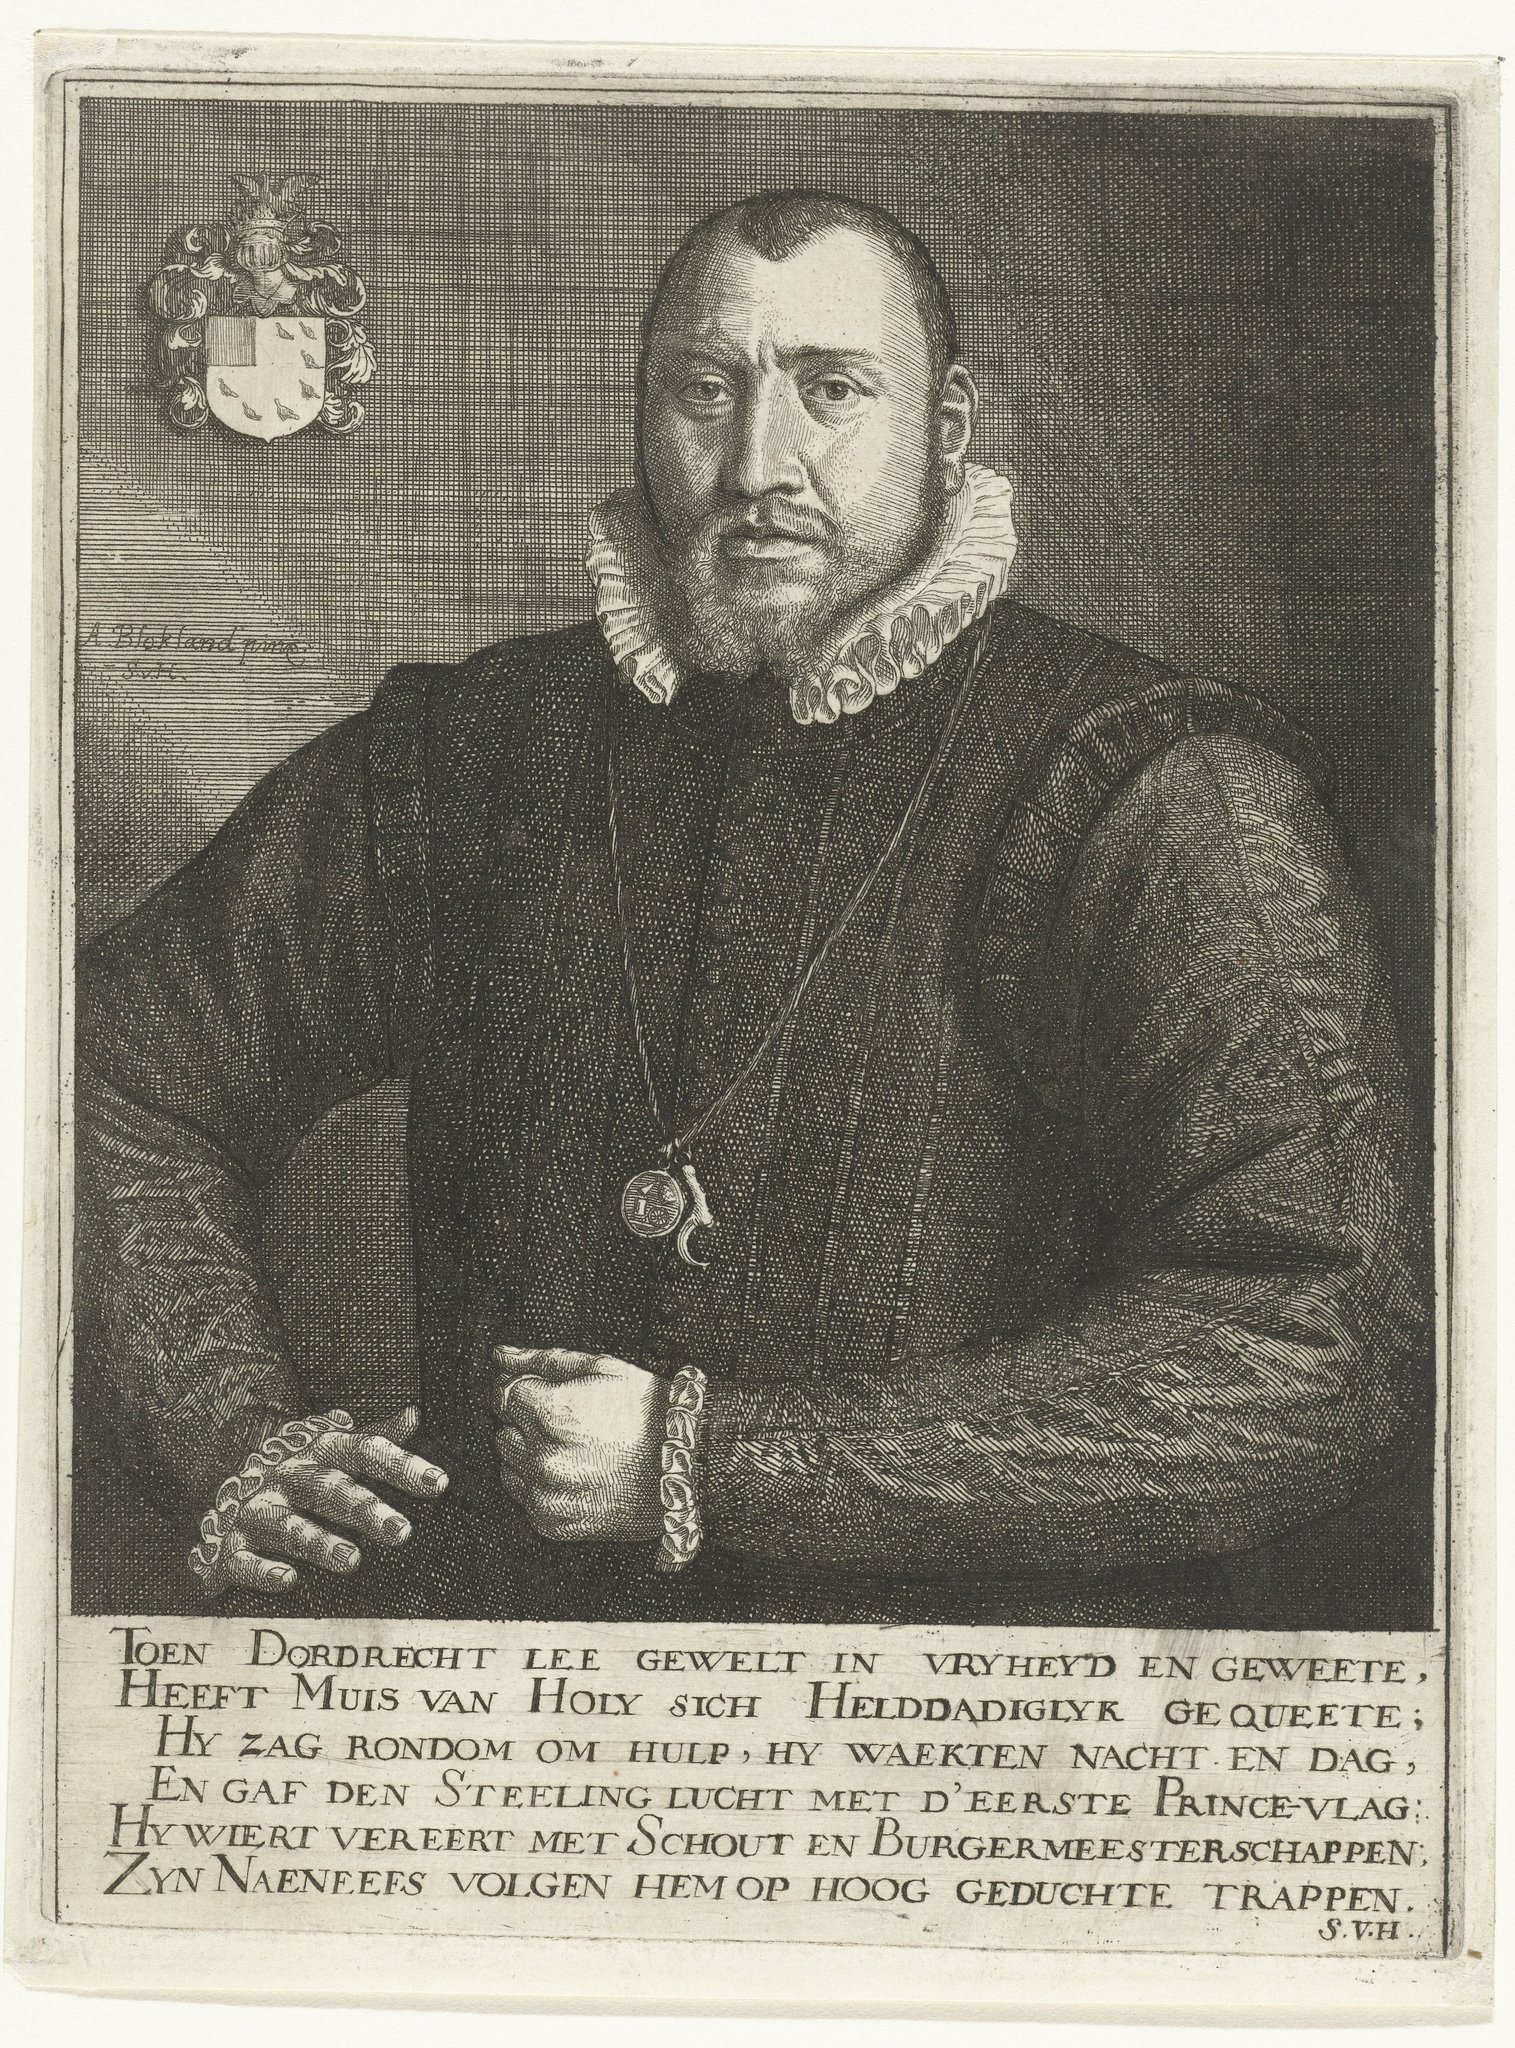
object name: print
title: Portret van Jacob Muys van Holy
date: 1648-1677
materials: paper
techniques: etching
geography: netherlands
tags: dordrecht, mayor, mayor, burgomaster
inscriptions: collector's mark: Lugt 2228a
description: Jacob Muys van Holy, burgemeester van Dordrecht, ten halven lijve. Linksboven het wapen van Holy. Onder het portret een zesregelige tekst in het Nederlands.